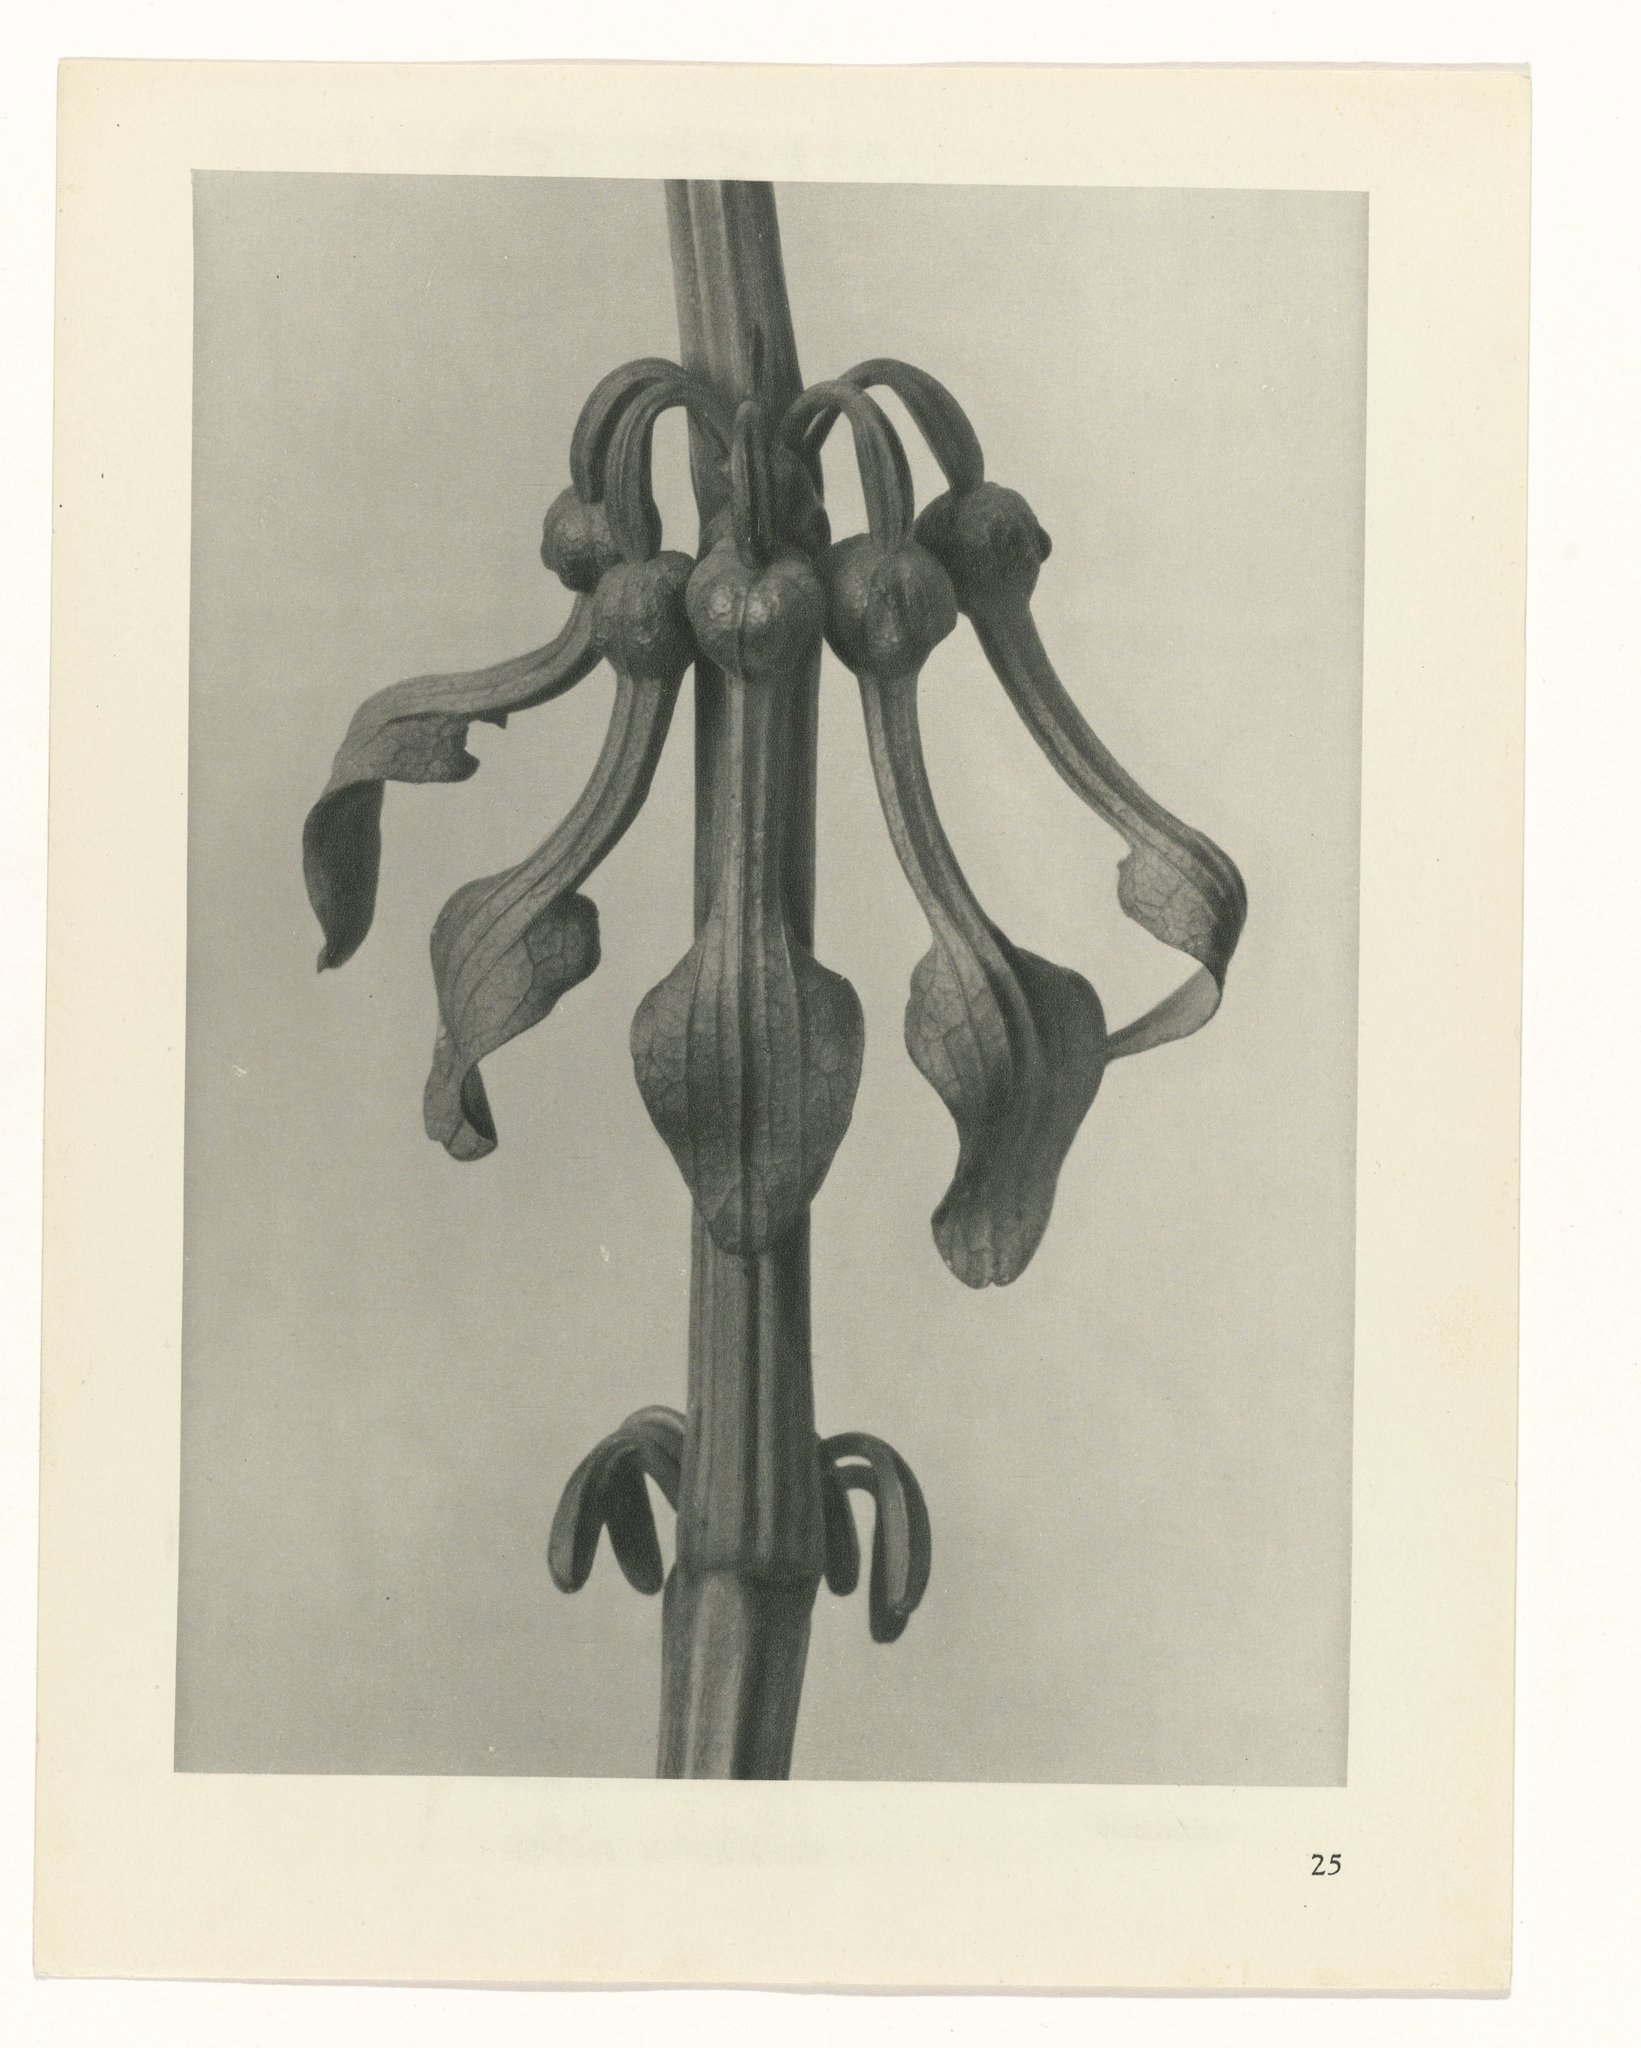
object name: photograph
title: Urformen der Kunst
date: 1928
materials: ink, paper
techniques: rotogravure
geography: berlin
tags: plants (in general)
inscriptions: number: ‘25’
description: facher Vergrößerung. Afkomstig uit losbladige uitgave.